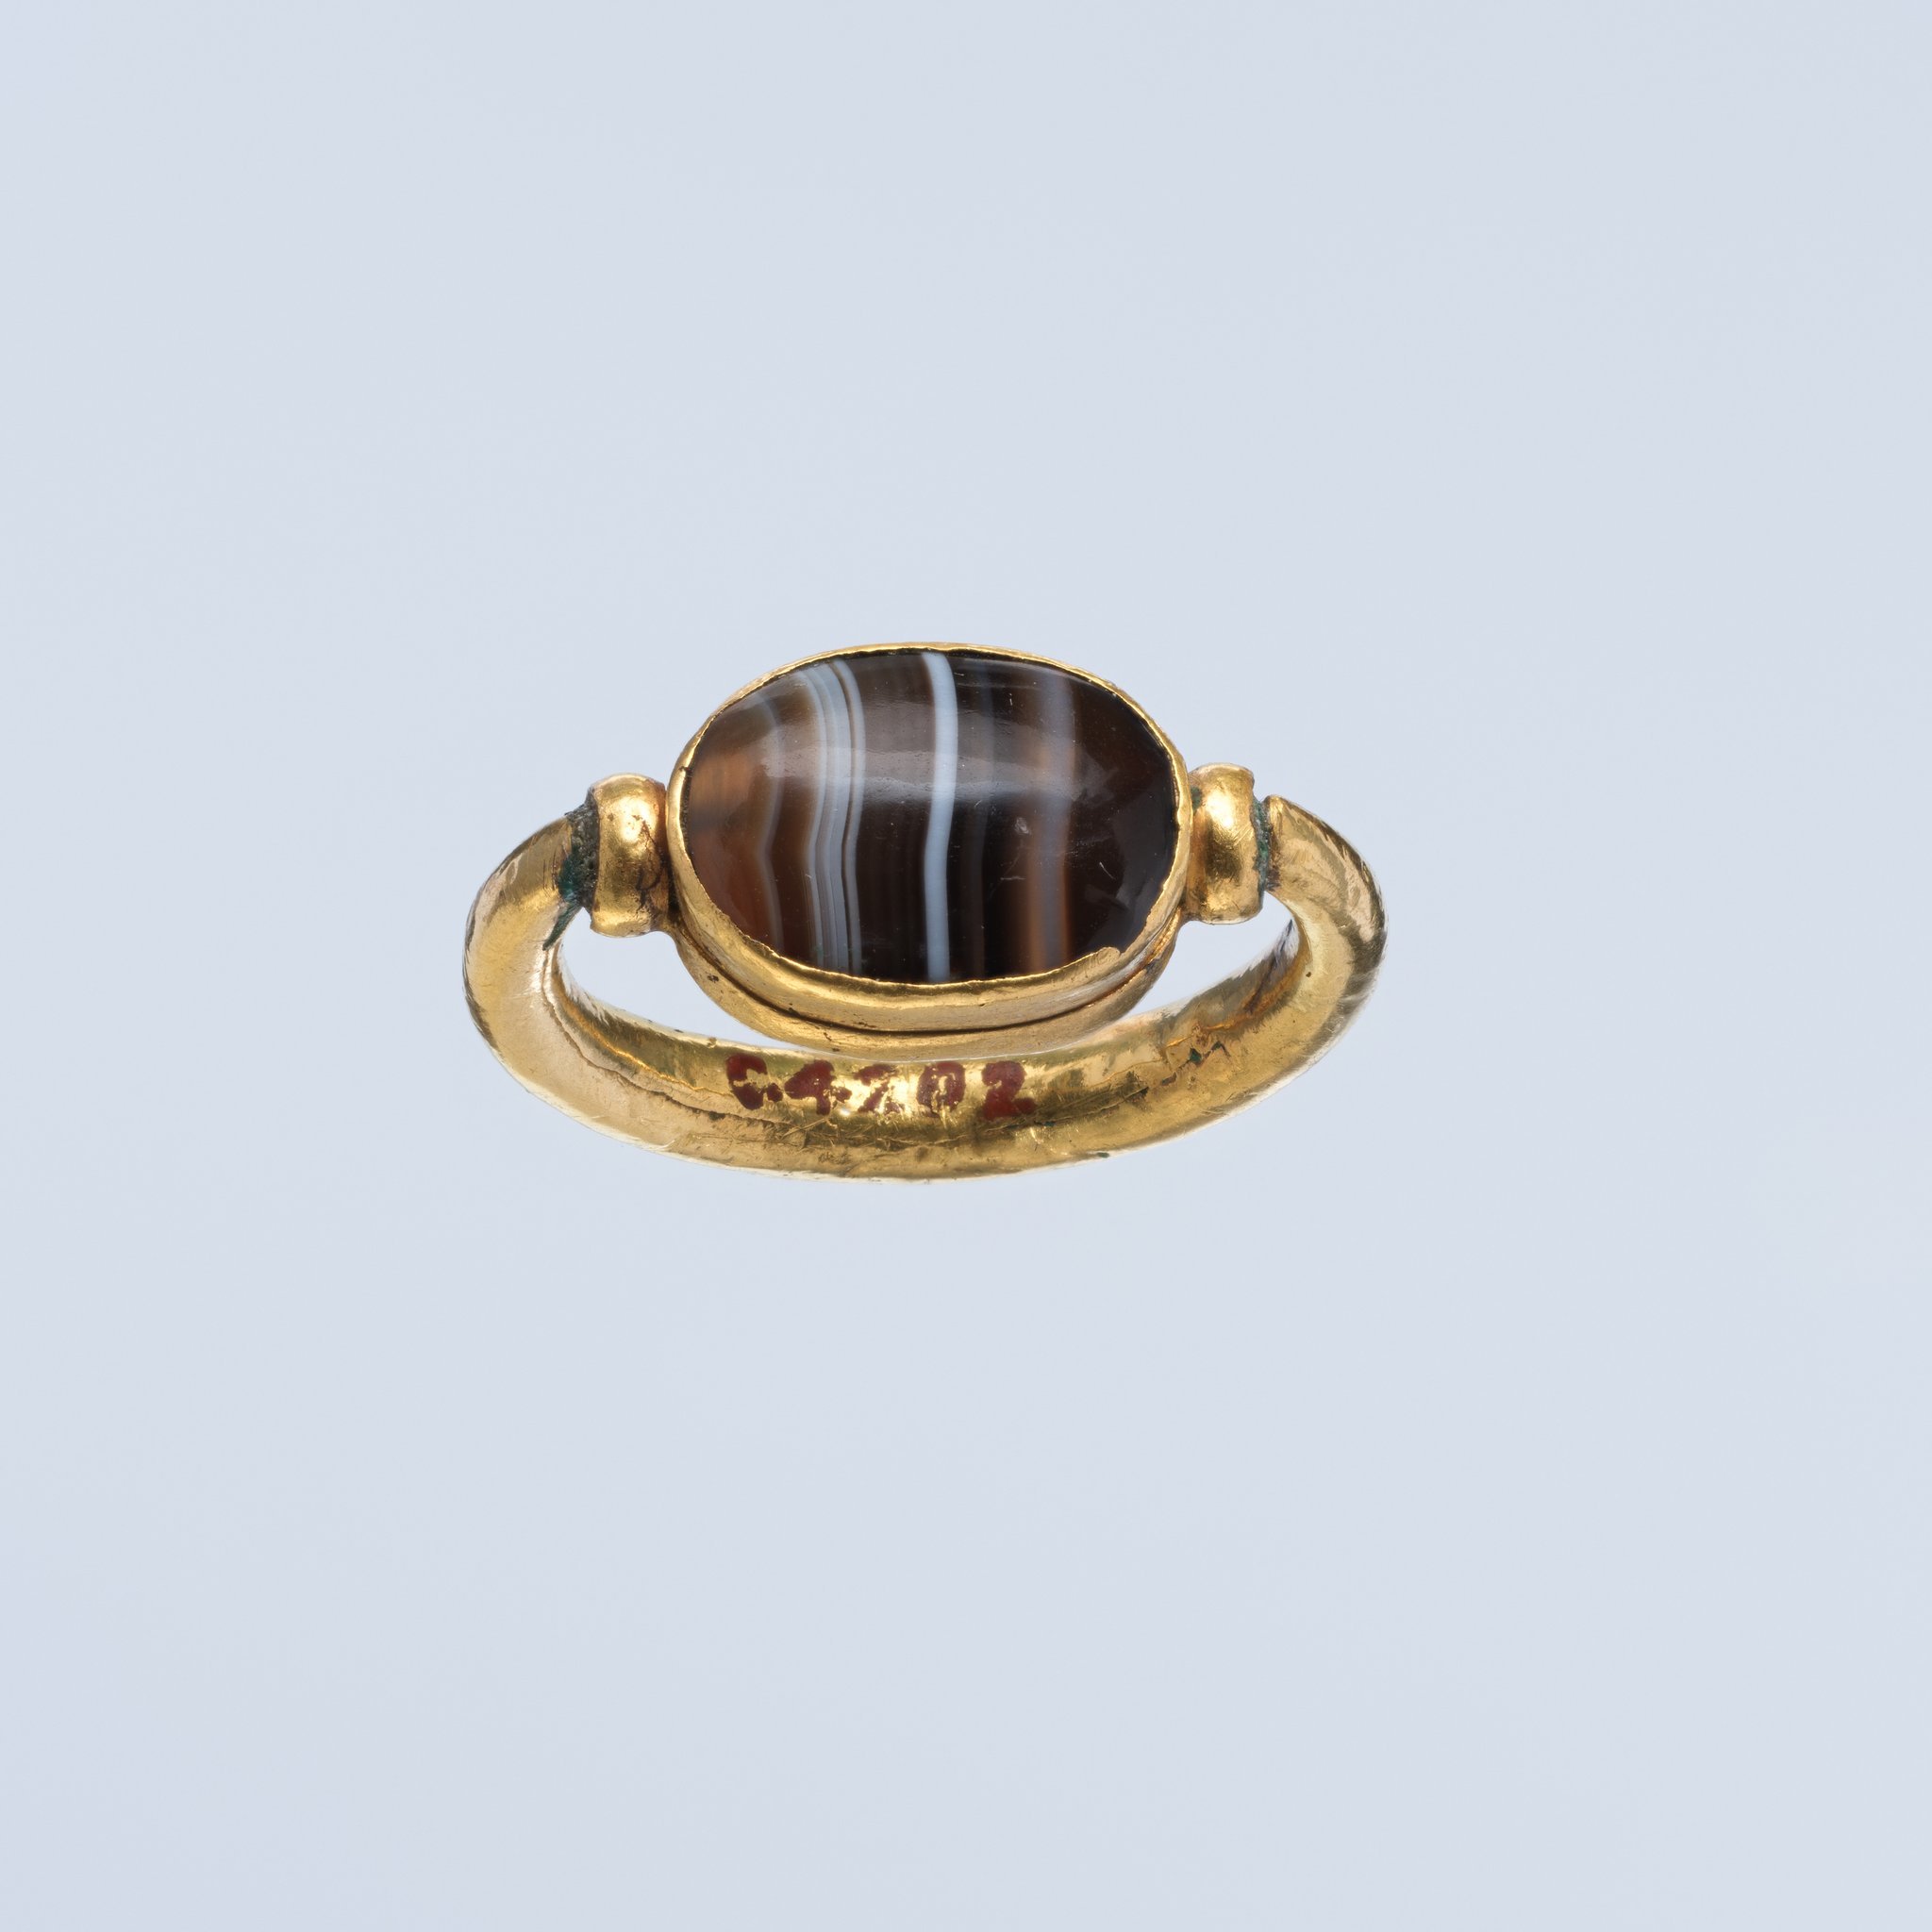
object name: ring with scaraboid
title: Gold ring with plain agate scaraboid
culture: greek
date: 500-401 BCE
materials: stone, gold